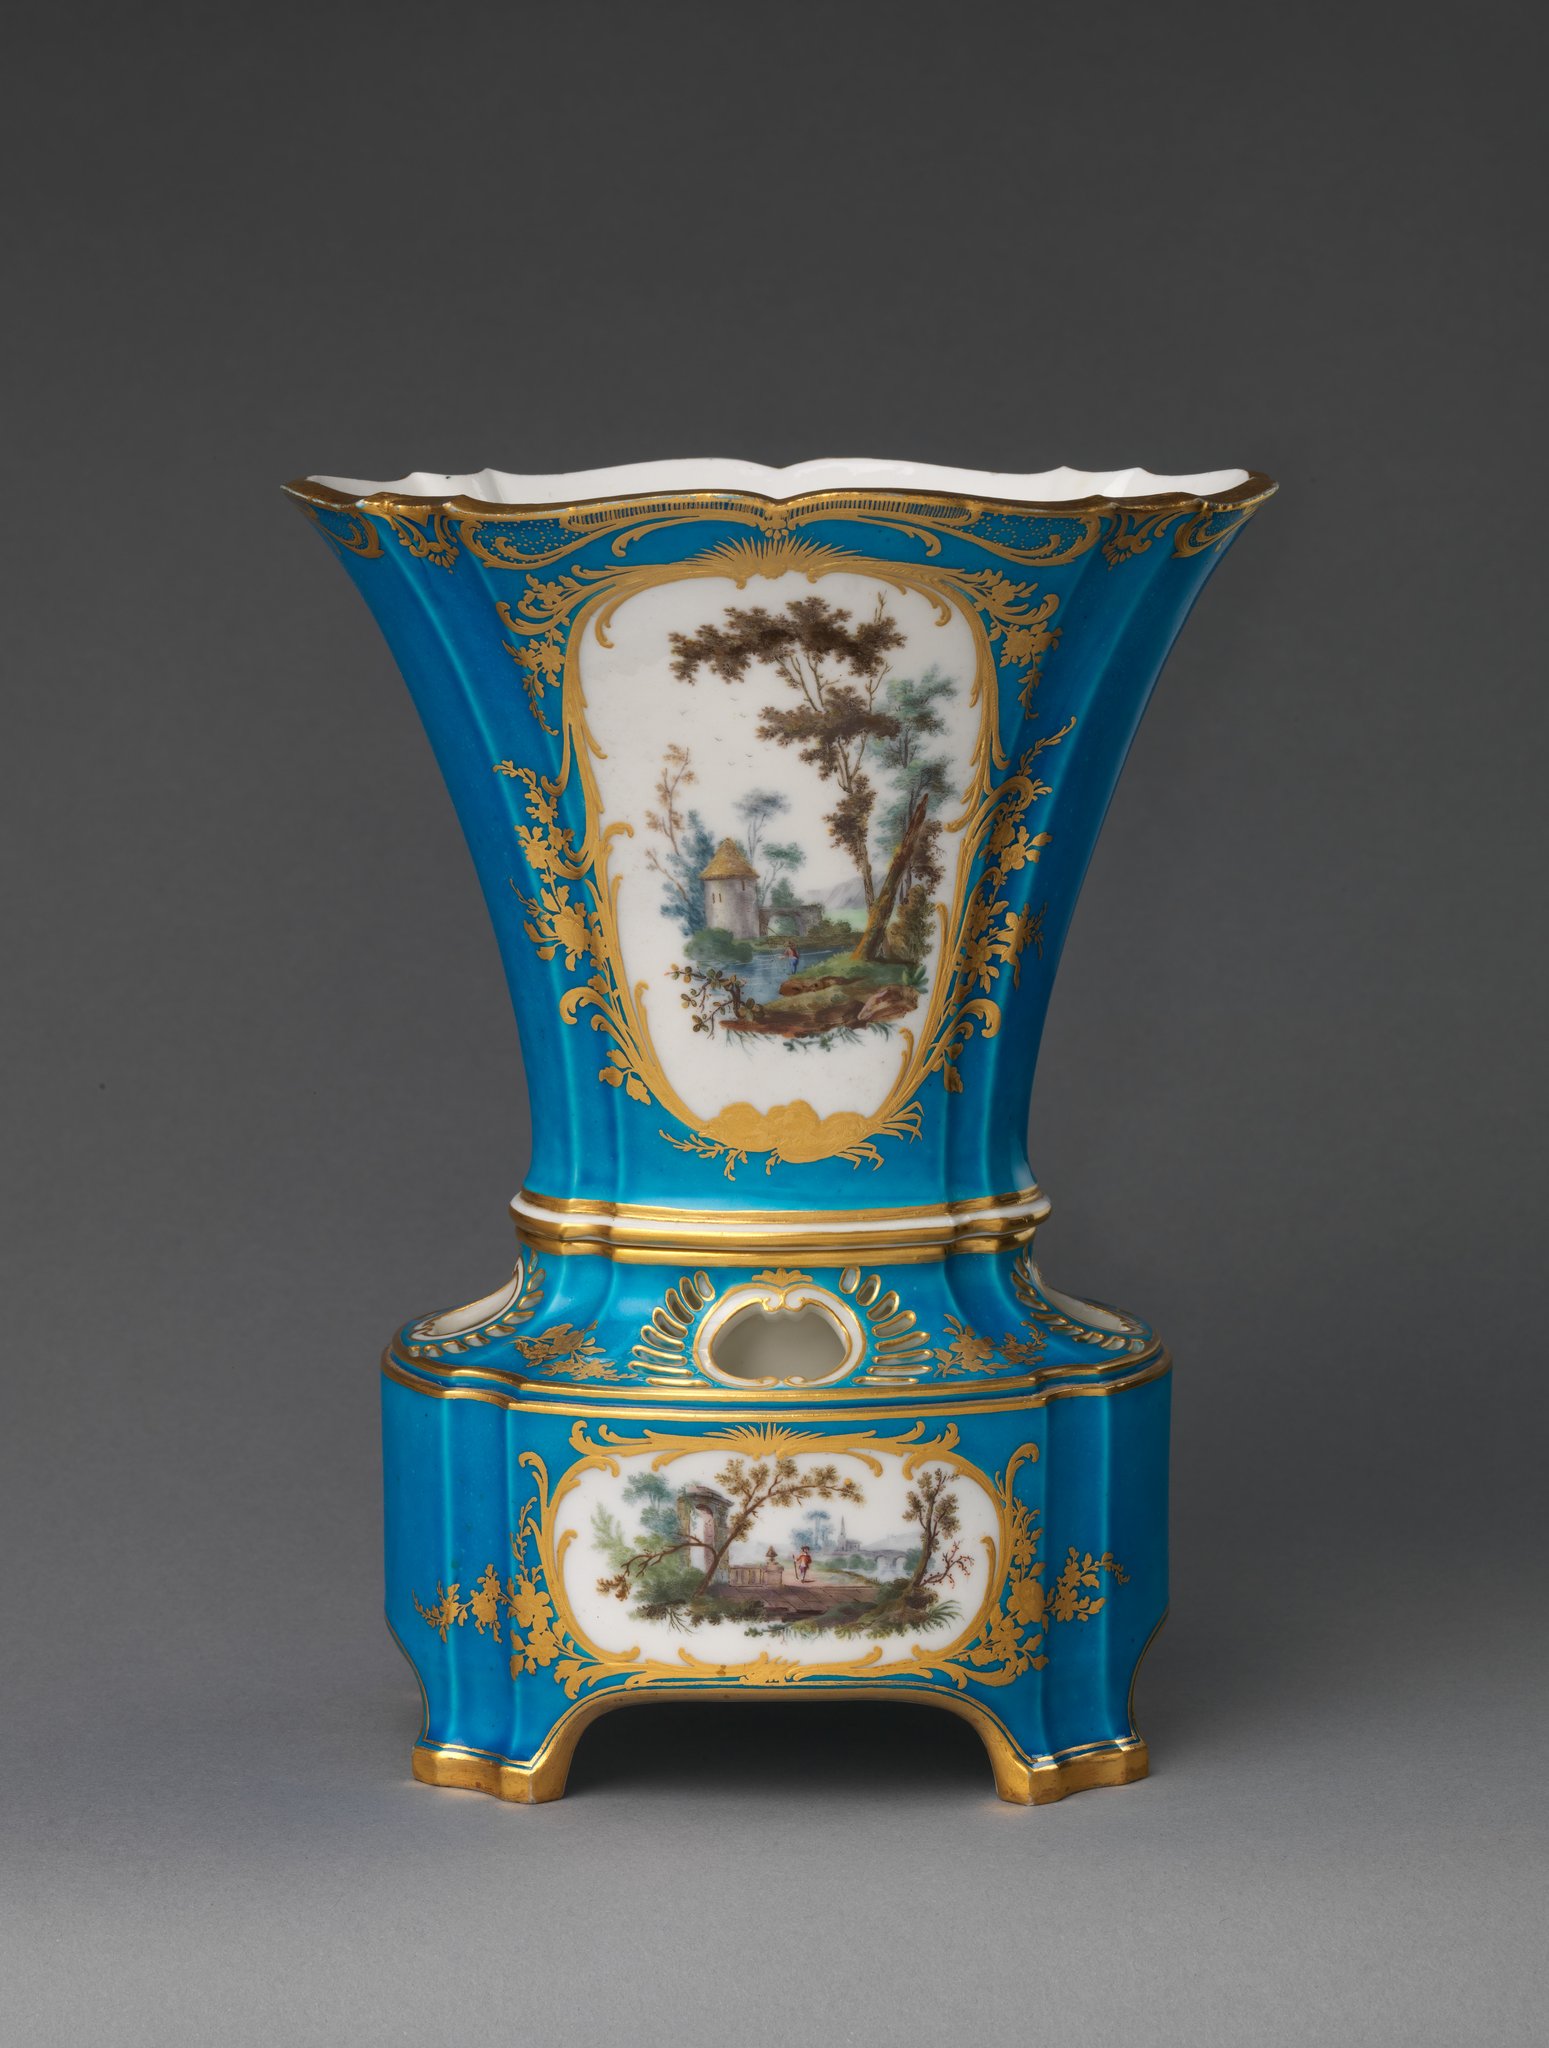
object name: flower vase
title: Flower vase (vase hollandais nouveau) (one of a pair)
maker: sèvres manufactory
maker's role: manufactory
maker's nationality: french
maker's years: 1740-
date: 1759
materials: soft paste porcelain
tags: landscapes